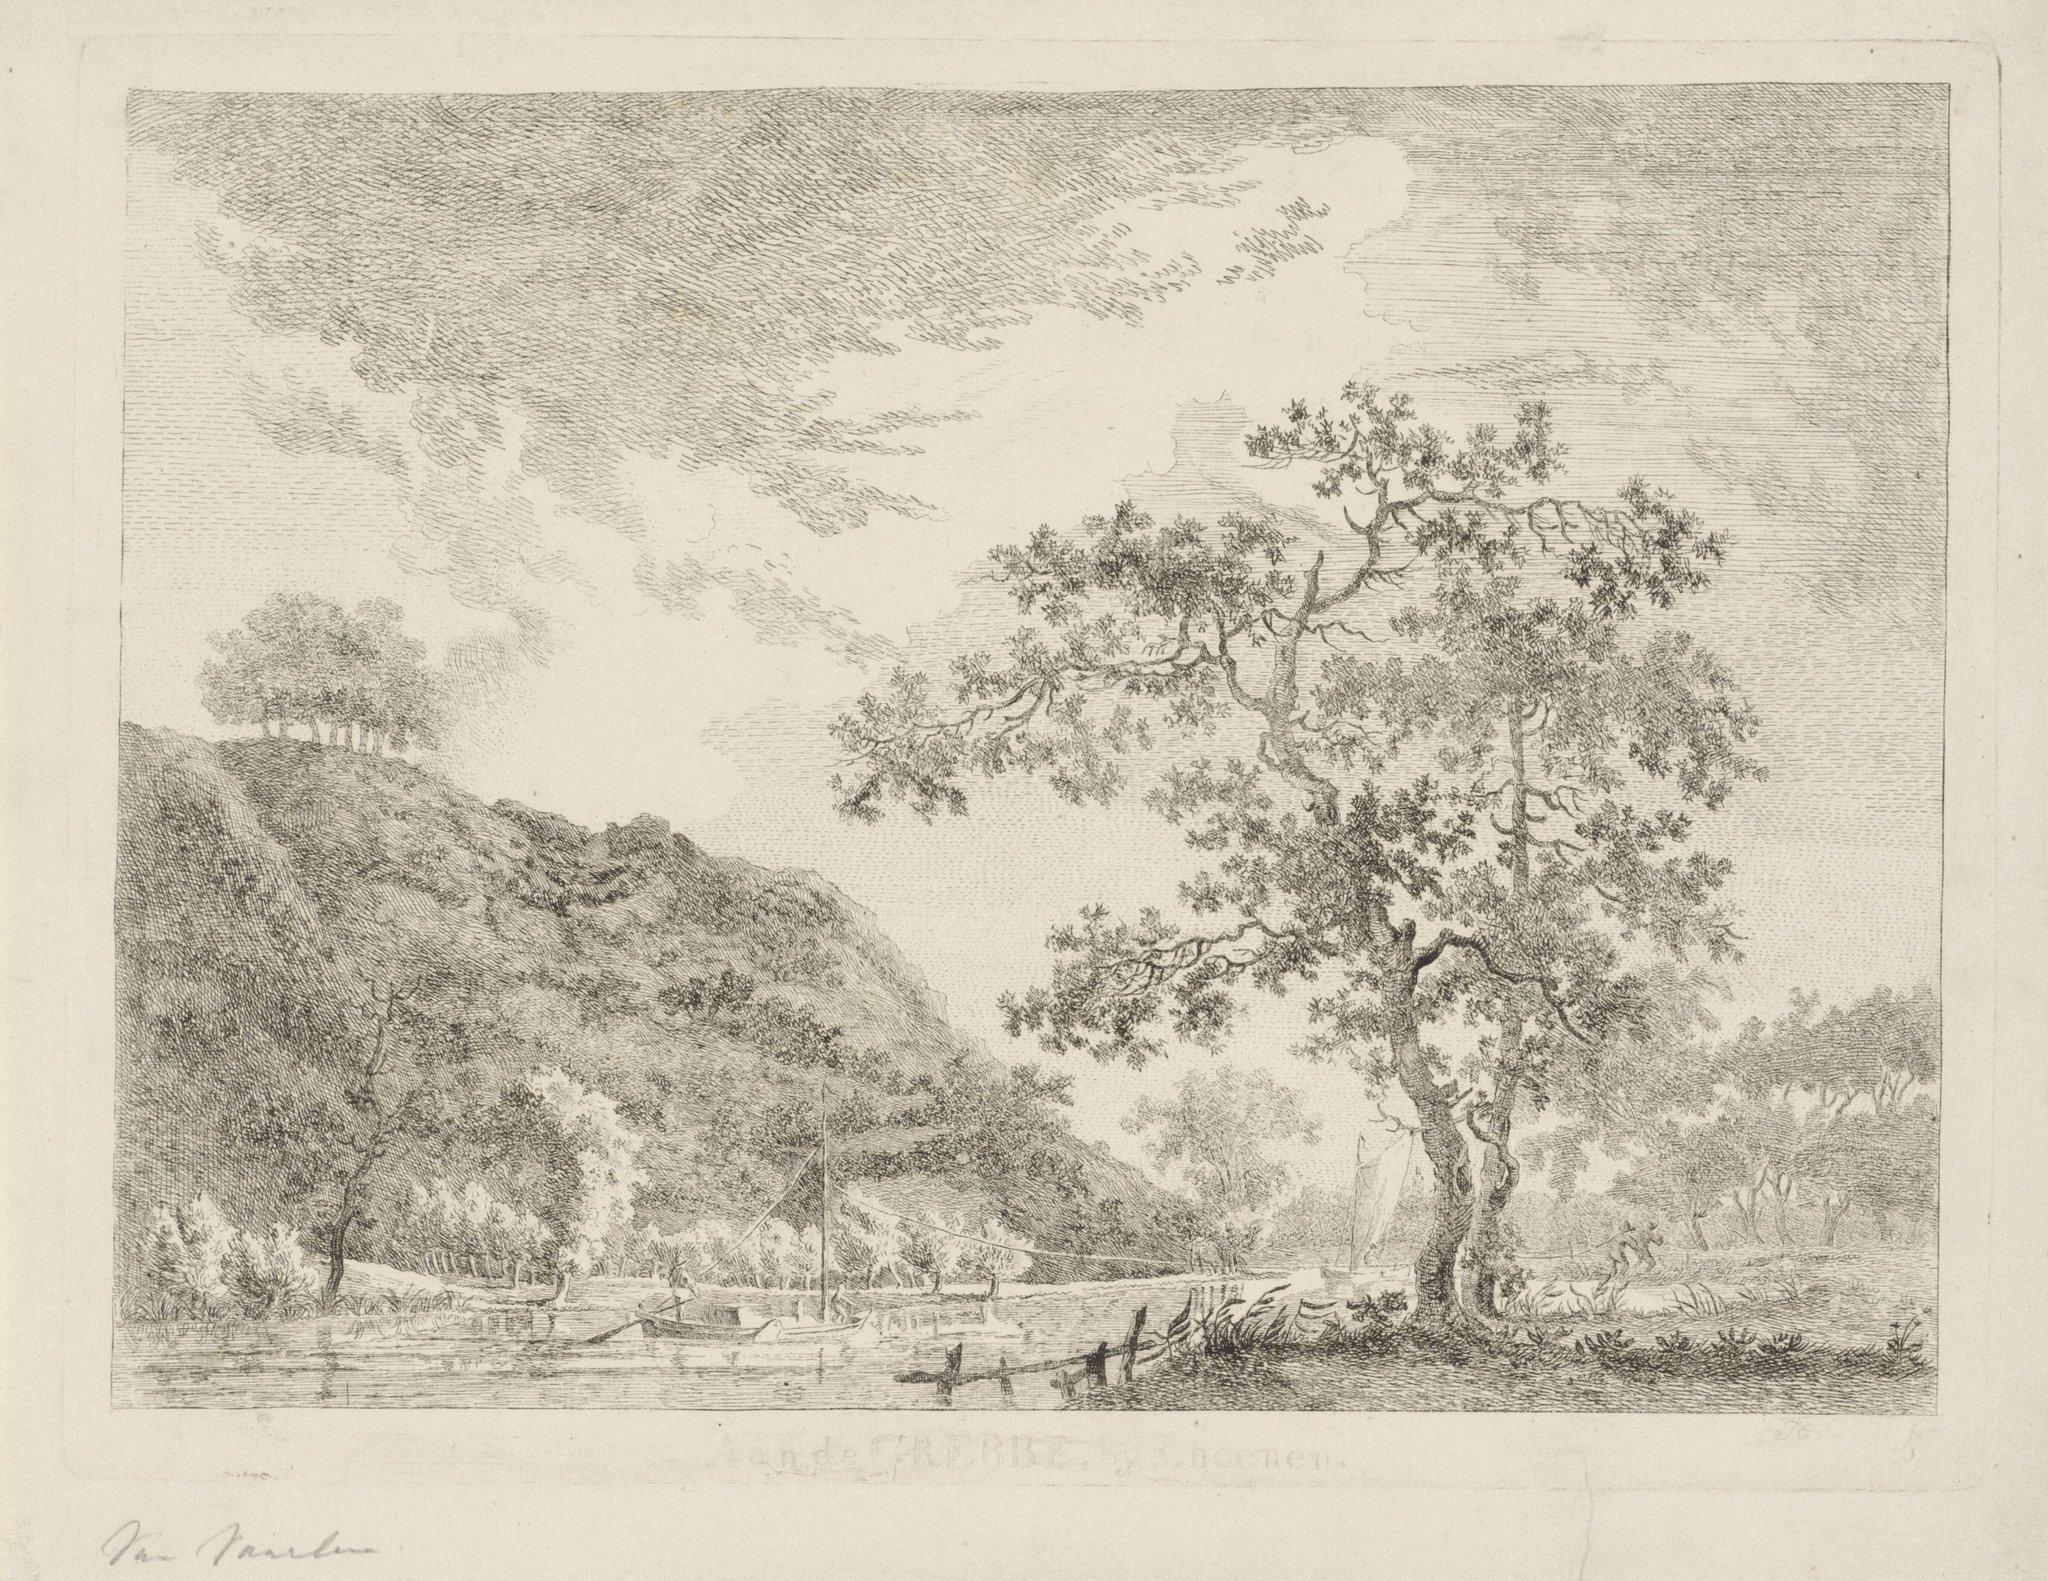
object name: print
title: Gezicht op de berg aan de Grebbe bij Rhenen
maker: jacob elias van varelen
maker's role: draughtsman, print maker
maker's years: 1757-1840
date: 1772-1840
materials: paper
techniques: etching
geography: haarlem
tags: river, water course (+ landscape with figures, staffage), towing path, rhenen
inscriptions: collector's mark: Lugt 2228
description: Figuren op een jaagpad en een schuit op een rivier de Grebbe in een landschap bij een berg te Rhenen.